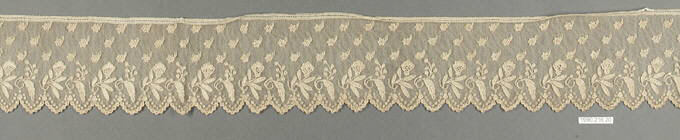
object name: edging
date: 1867-1900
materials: cotton, lace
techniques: lace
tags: flowers